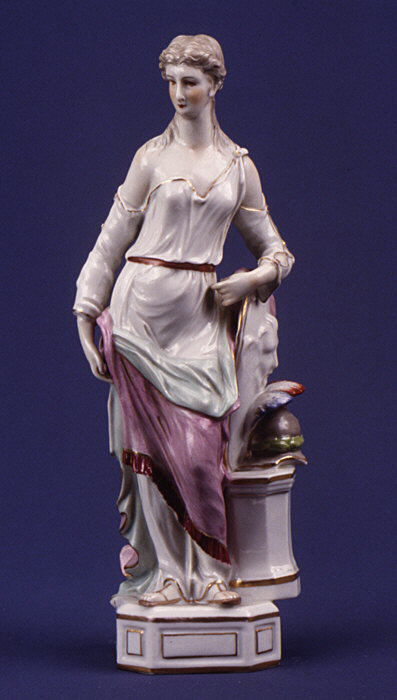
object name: figure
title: Minerva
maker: johann christian wilhelm beyer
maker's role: modeler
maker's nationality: german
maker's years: 1725-1806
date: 1801-2000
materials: hard paste porcelain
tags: minerva